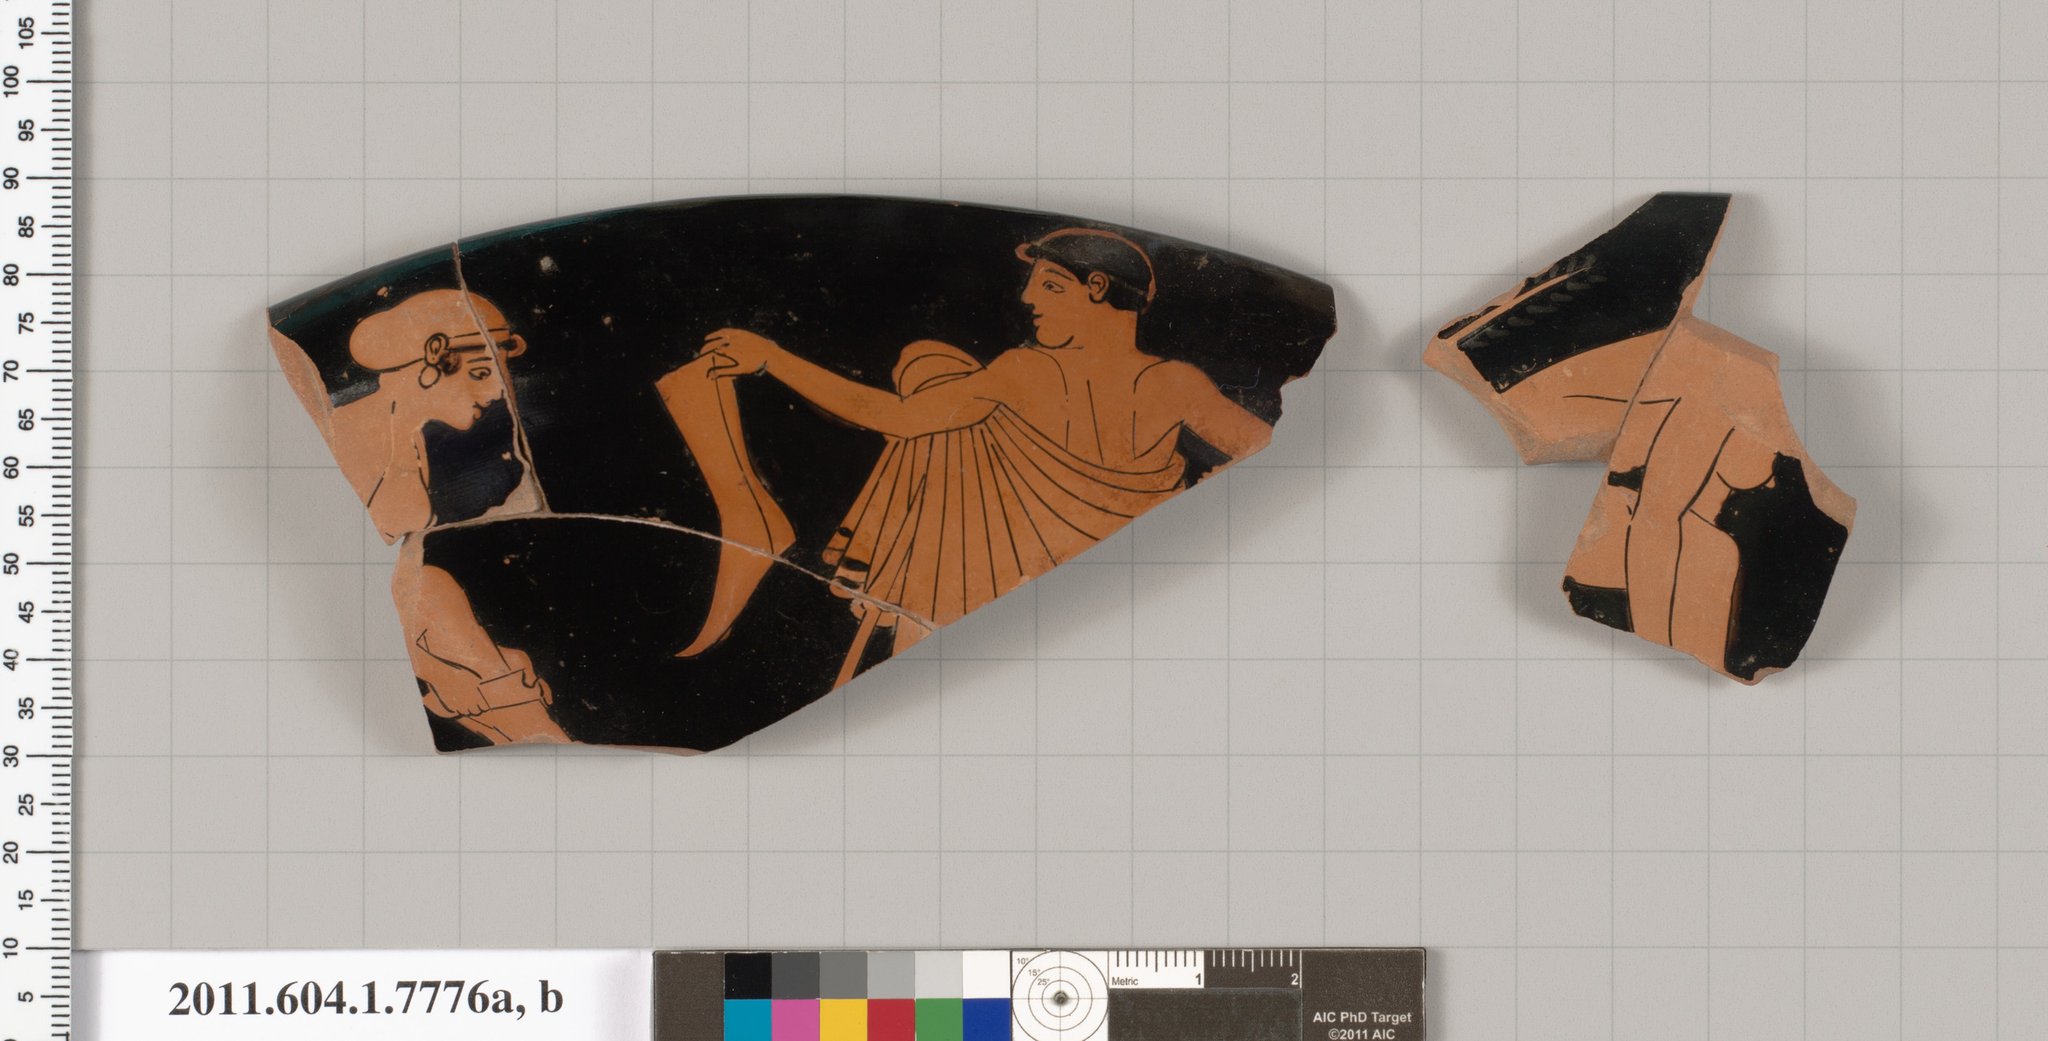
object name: kylix fragment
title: Terracotta rim fragments of a kylix (drinking cup)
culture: greek, attic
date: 460-450 BCE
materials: terracotta